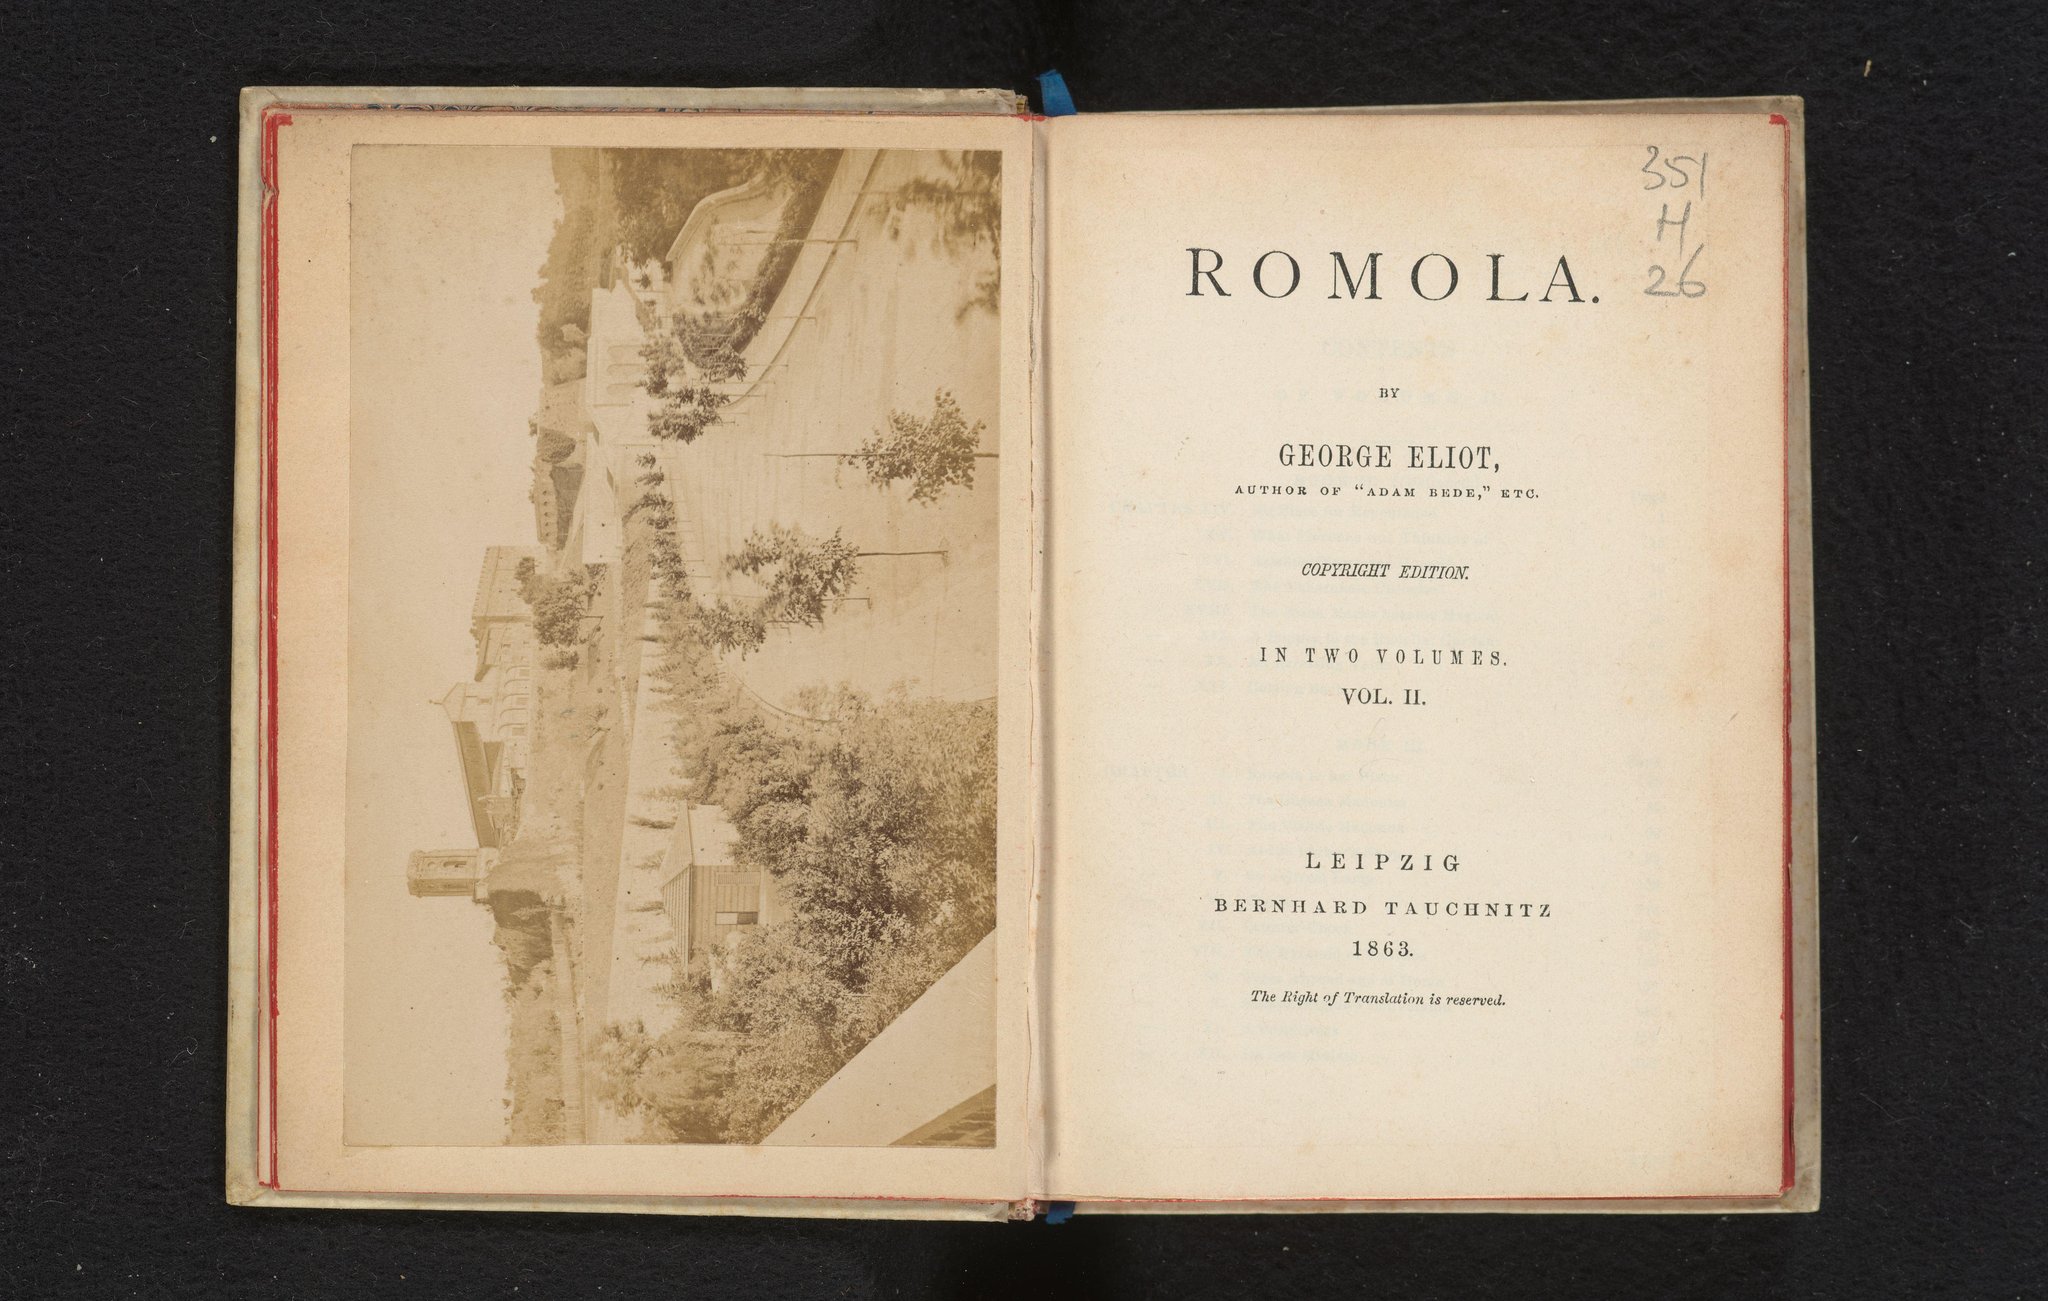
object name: book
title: Romola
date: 1863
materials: cardboard, paper, parchment, textile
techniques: albumen print, letterpress printing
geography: leipzig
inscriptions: bookplate: ‘Pax et spes/ I.A. Pease’, inscription: ‘vol. II 29 albumines dont/ 9 reproductions’, retailer's mark: ‘Edward Goodban’